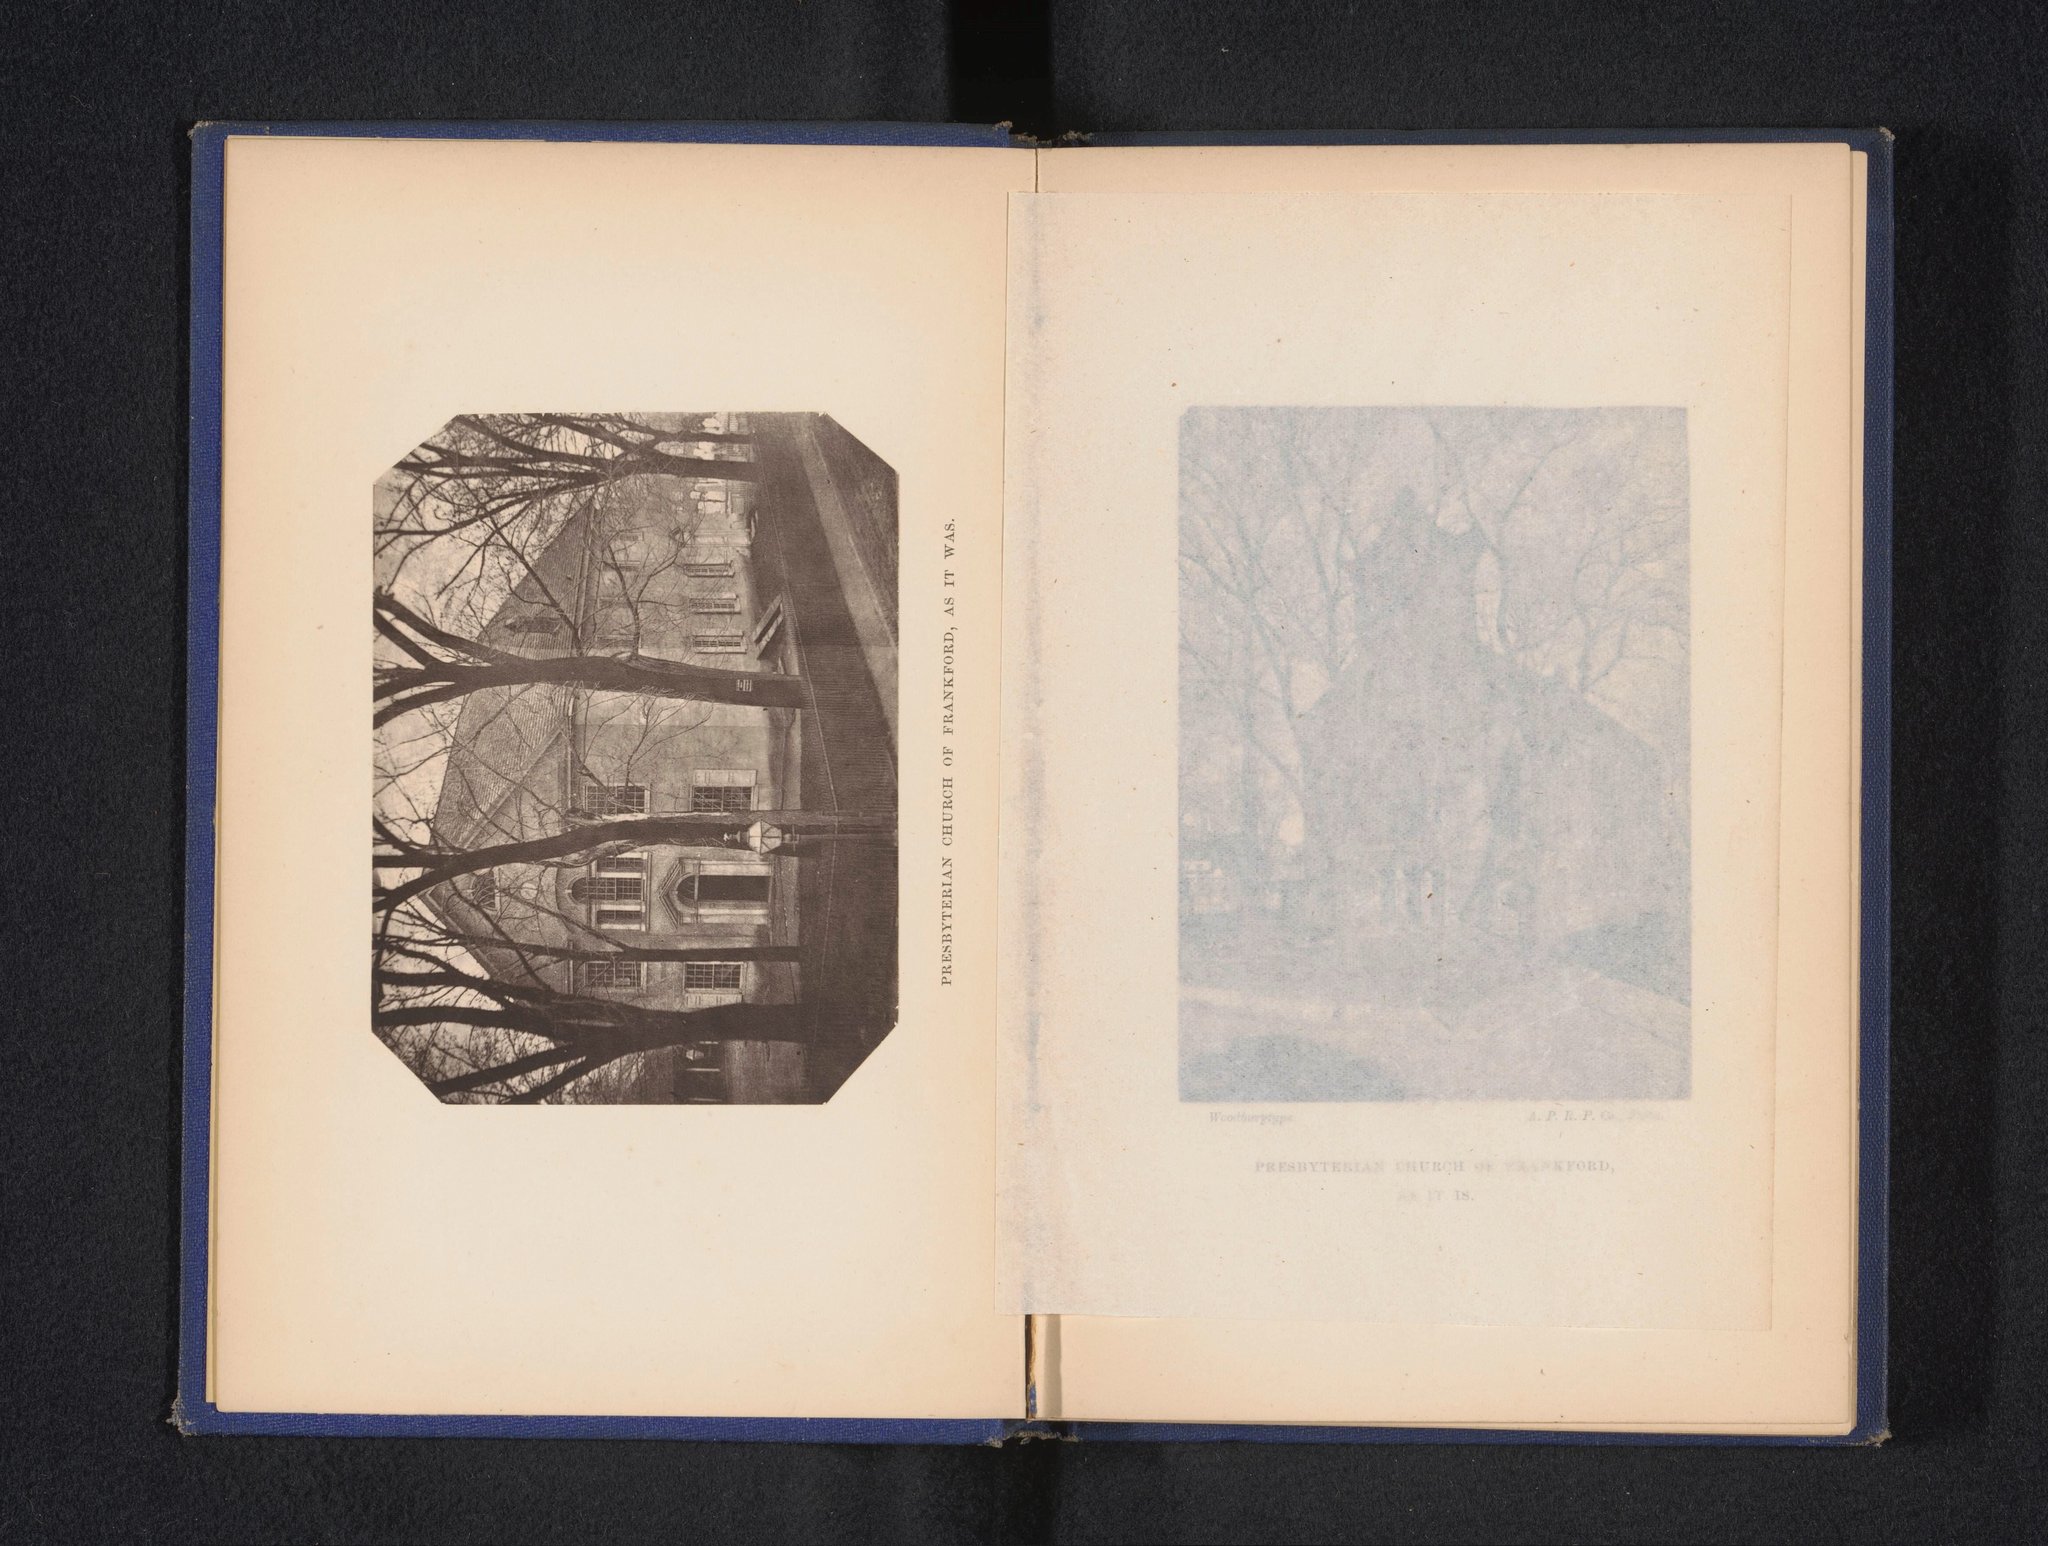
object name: page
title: Presbyterian church of Frankford, as it was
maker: Anonymous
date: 1867-1872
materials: paper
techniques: woodburytype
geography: frankford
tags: church (exterior)